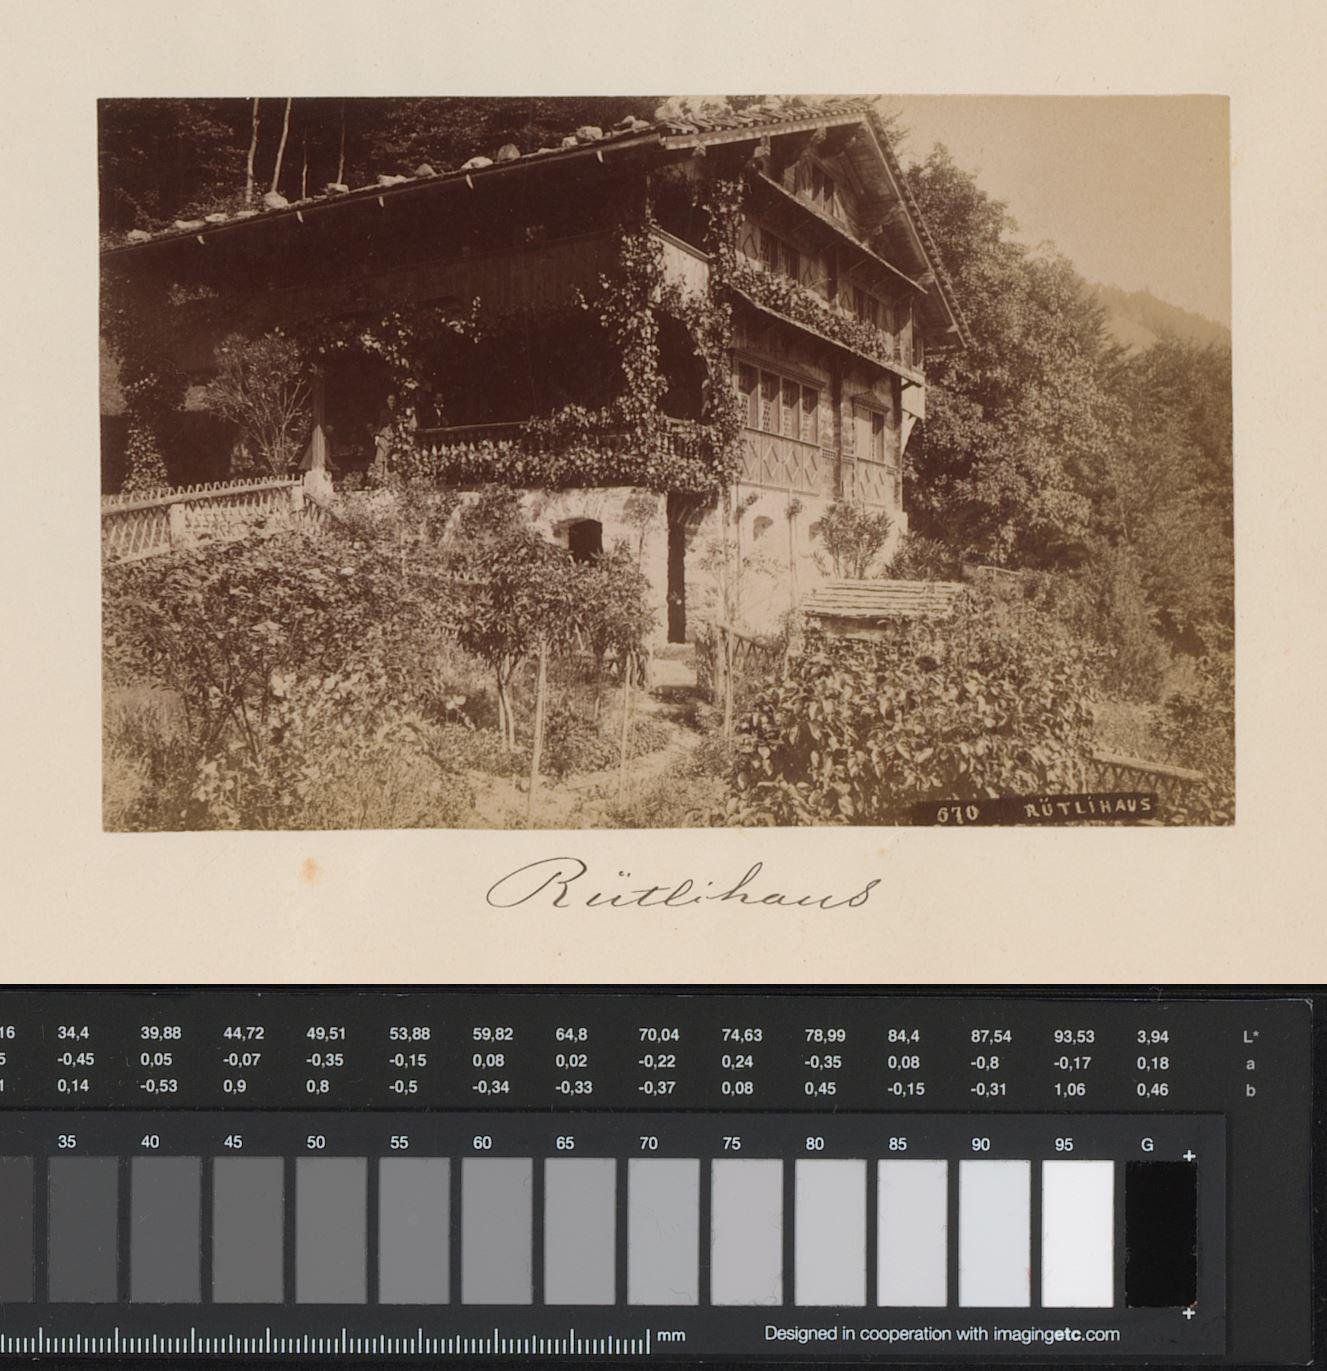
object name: album leaf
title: Gezicht op een woning in de alpenweide Rütli te Seelisberg, Zwitserland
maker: Anonymous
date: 1860-1900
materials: photographic support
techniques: albumen print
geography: seelisberg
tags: meadow, pasture, rural housing, e.g. country-house, villa, cottage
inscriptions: inscription: ‘670 Rütlihaus’